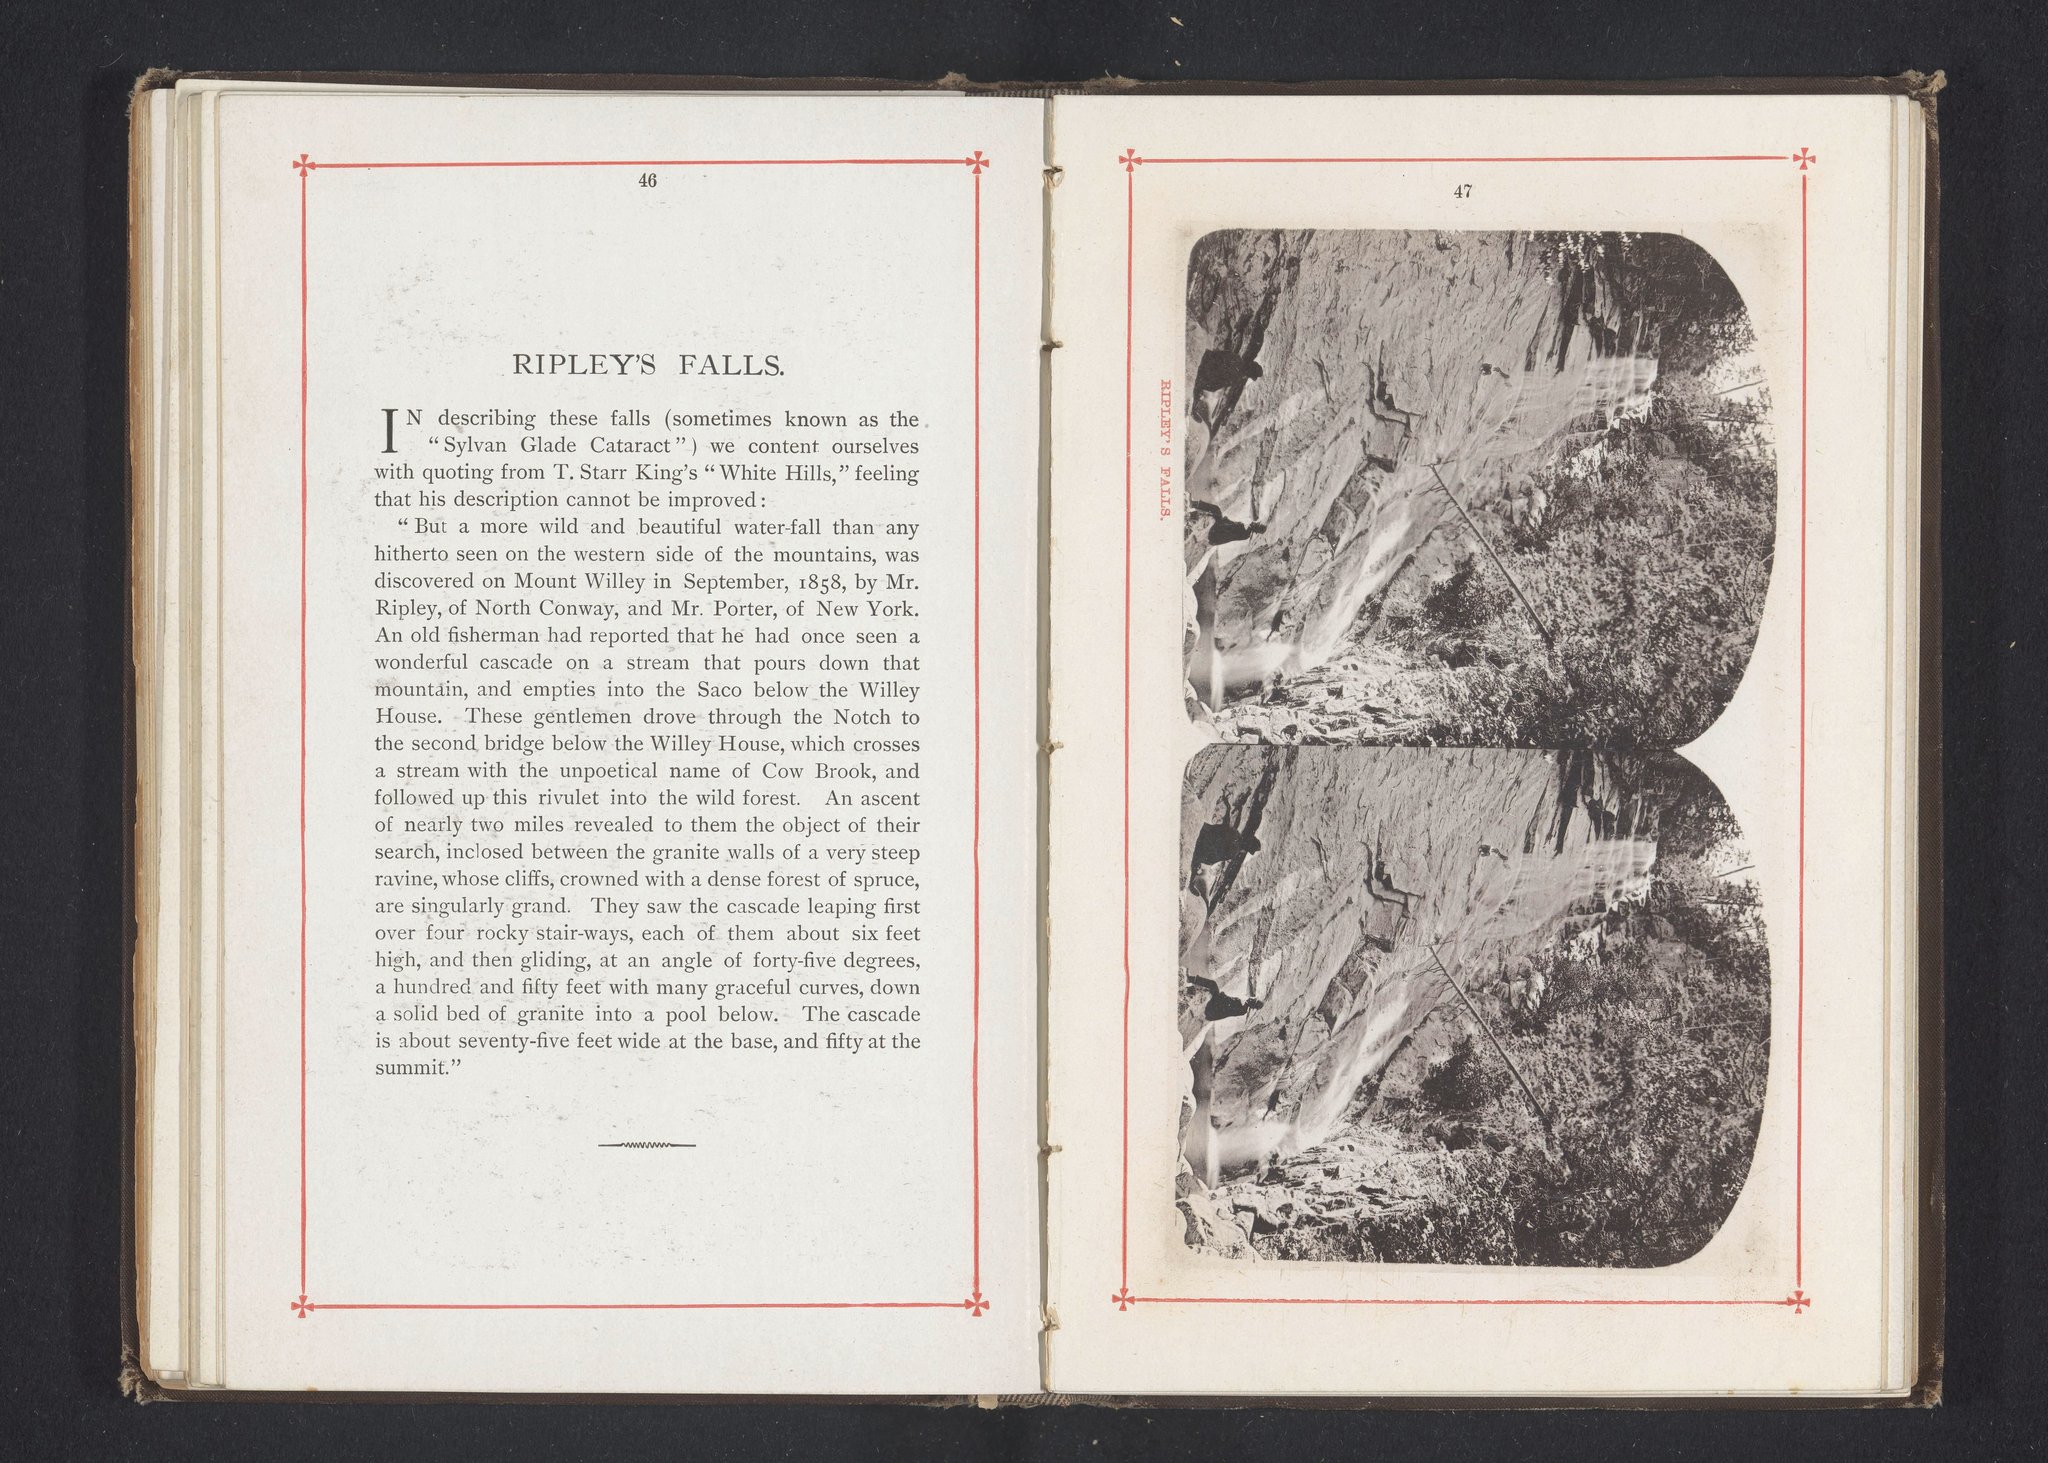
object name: stereograph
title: Gezicht op een waterval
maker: Anonymous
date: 1873-1878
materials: paper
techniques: photograph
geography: franconia notch state park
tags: waterfall, forest, wood